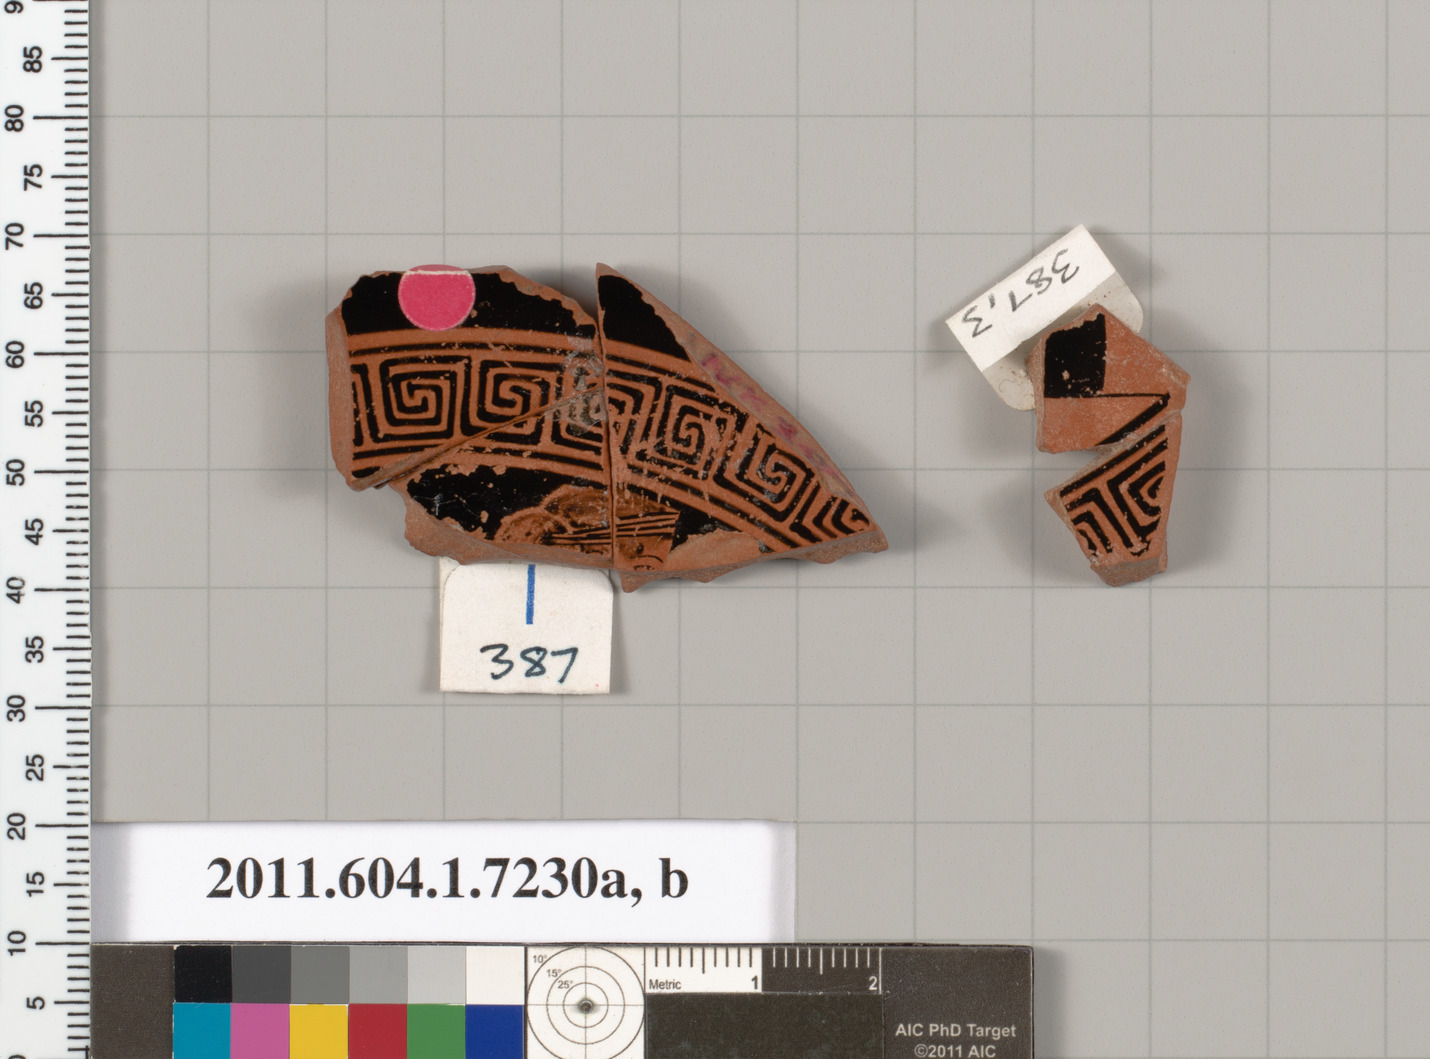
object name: kylix fragment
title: Terracotta fragments of a kylix (drinking cup)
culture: greek, attic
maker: makron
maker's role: artist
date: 500-480 BCE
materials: terracotta